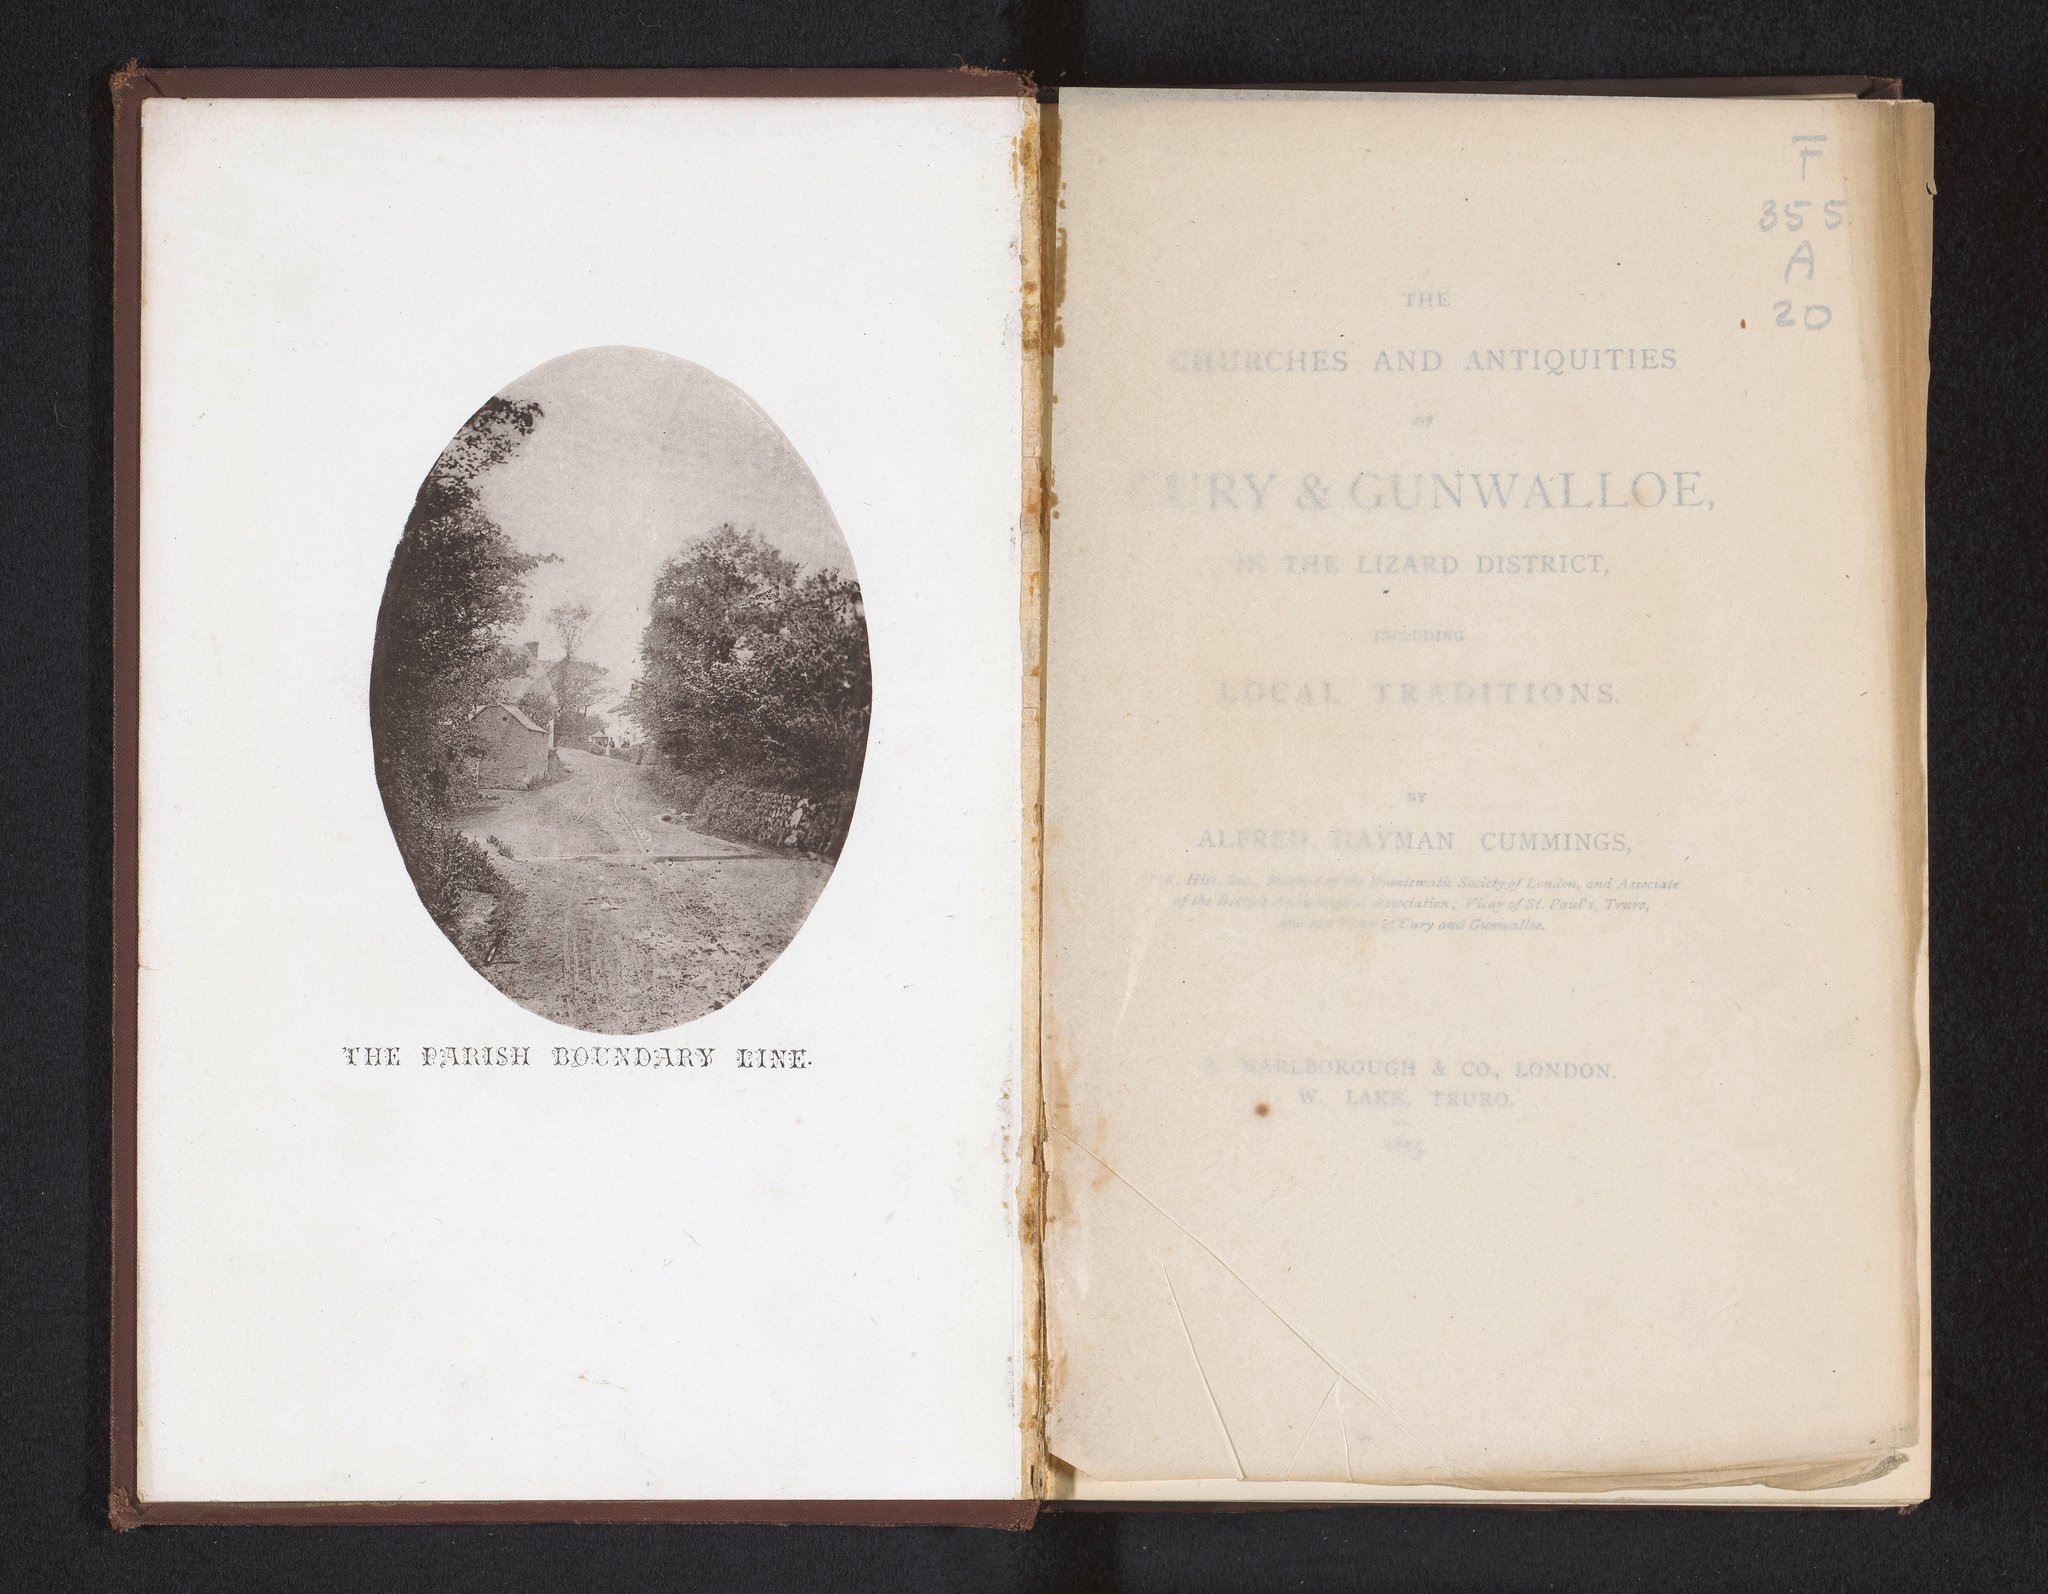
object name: photomechanical print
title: The parish boundary line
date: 1870-1875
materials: paper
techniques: photograph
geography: cornwall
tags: public road